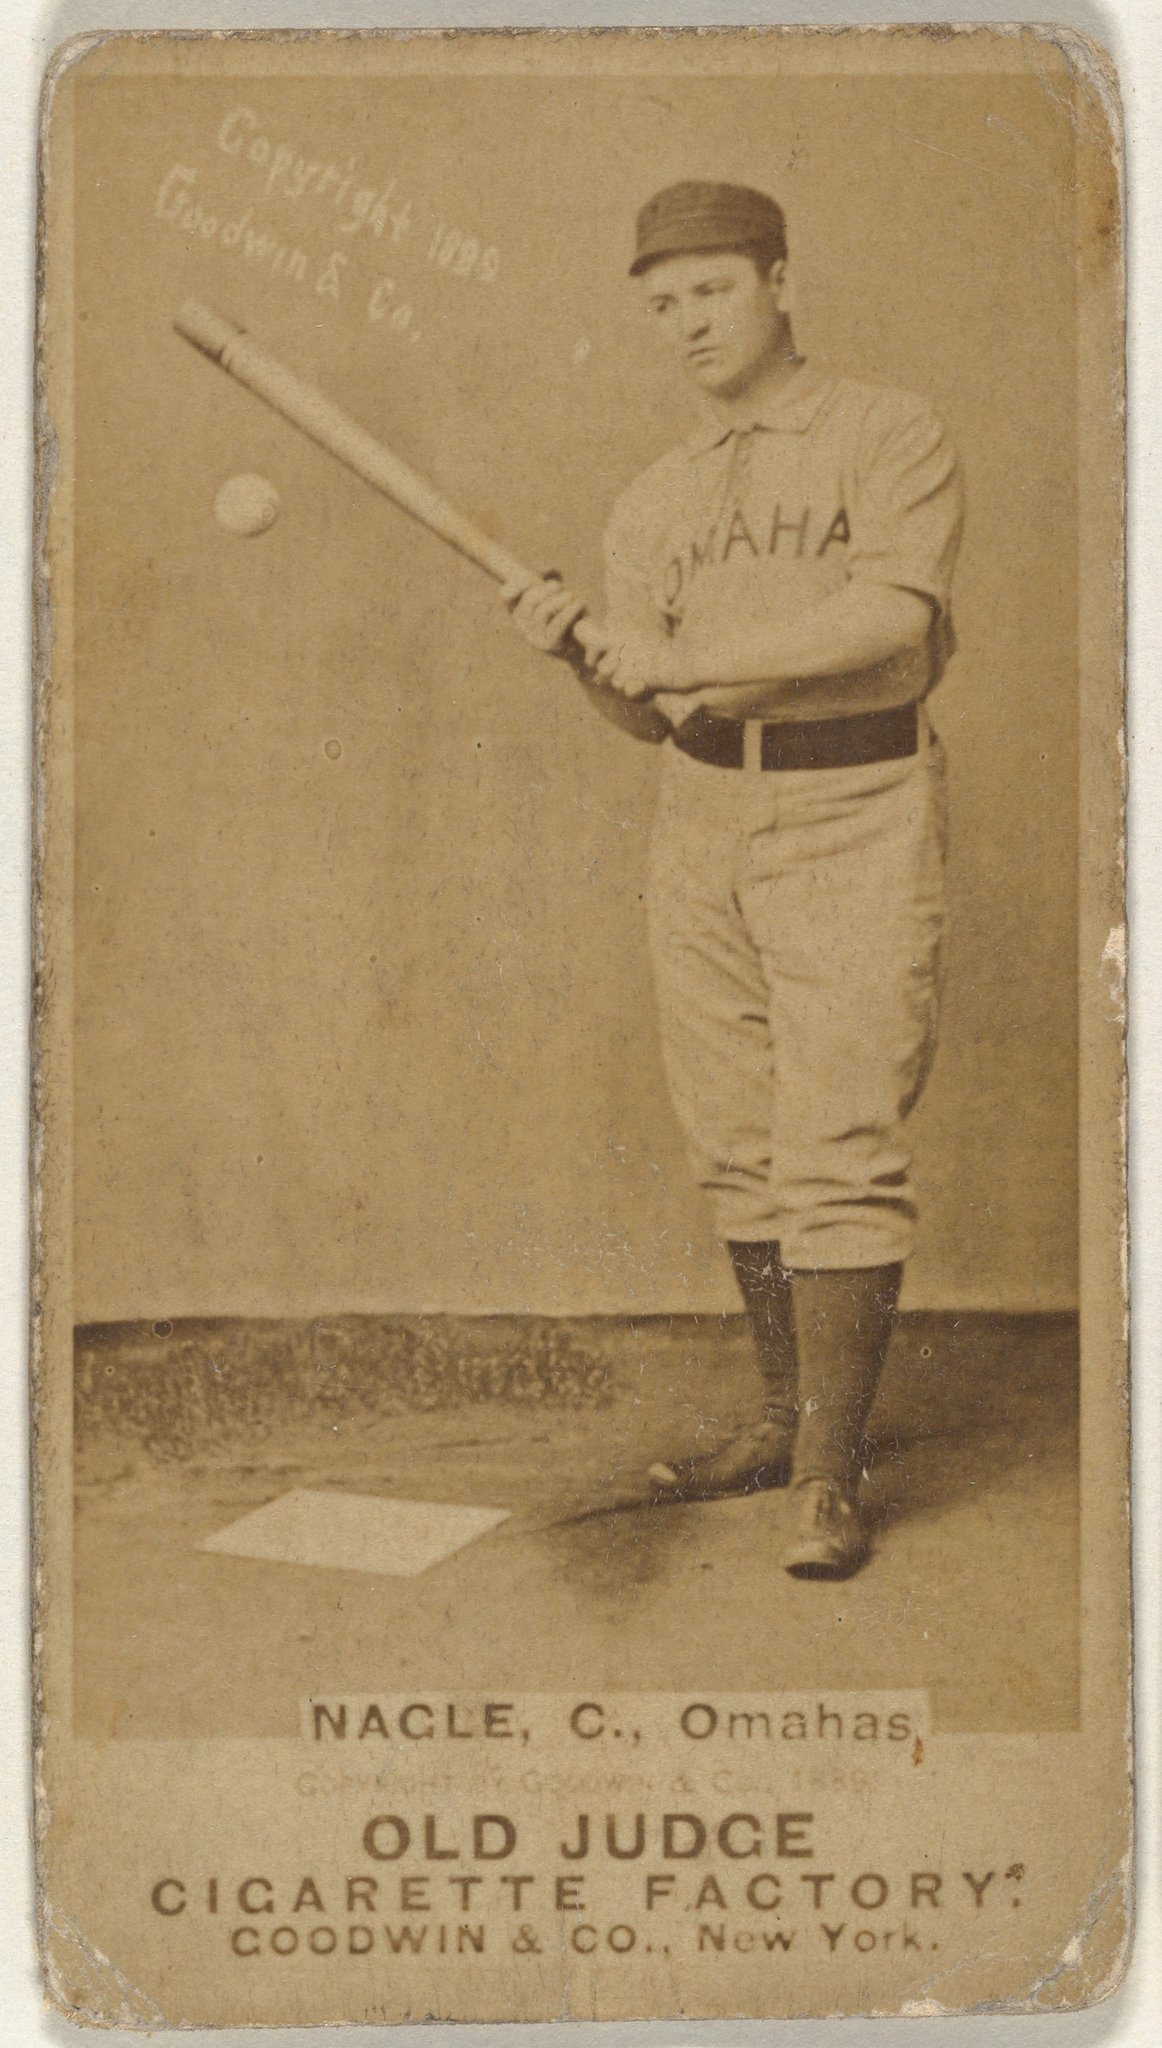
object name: baseball card, photograph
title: Nagle, Catcher, Omaha Omahogs/ Lambs, from the Old Judge series (N172) for Old Judge Cigarettes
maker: goodwin & company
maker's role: publisher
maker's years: 1850-1950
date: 1889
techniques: albumen silver print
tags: men,portraits,baseball,athletes